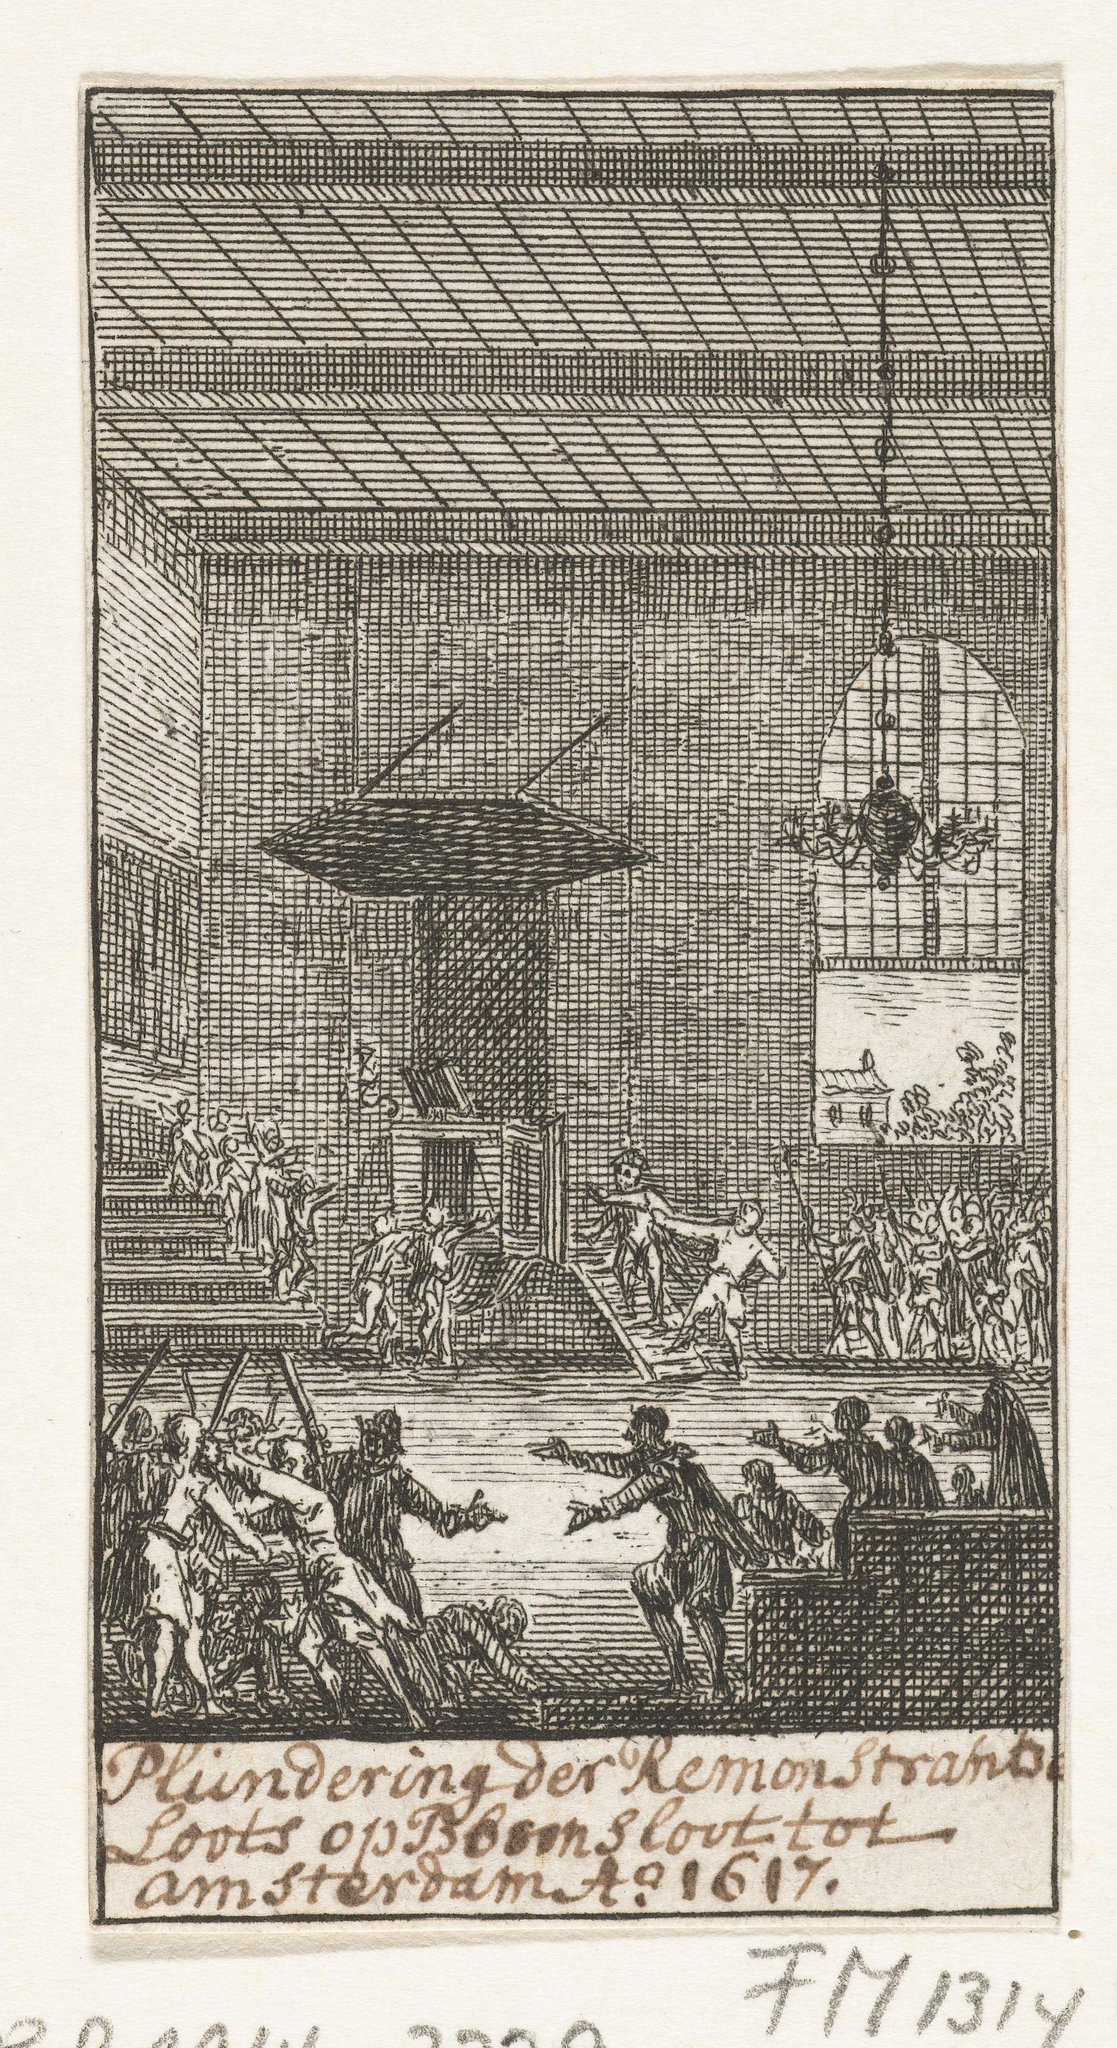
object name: print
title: Plundering van een Remonstrantse kerk te Amsterdam, 1617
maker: simon fokke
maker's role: draughtsman, print maker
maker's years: 1712-1784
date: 1722-1784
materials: paper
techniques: etching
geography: northern netherlands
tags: disturbance of religious service, amsterdam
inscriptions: inscription: ‘Plundering der remonstrantse Loots op Boomsloot tot amsterdam Ao. 1617’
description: Plundering van een Remonstrantse kerk aan de Boomsloot te Amsterdam, 2 februari 1617. Gezicht in de vergaderplaats: de kerkdienst verstoord, kerkgangers gemolesteerd en verjaagd, de predikant van de kansel getrokken.